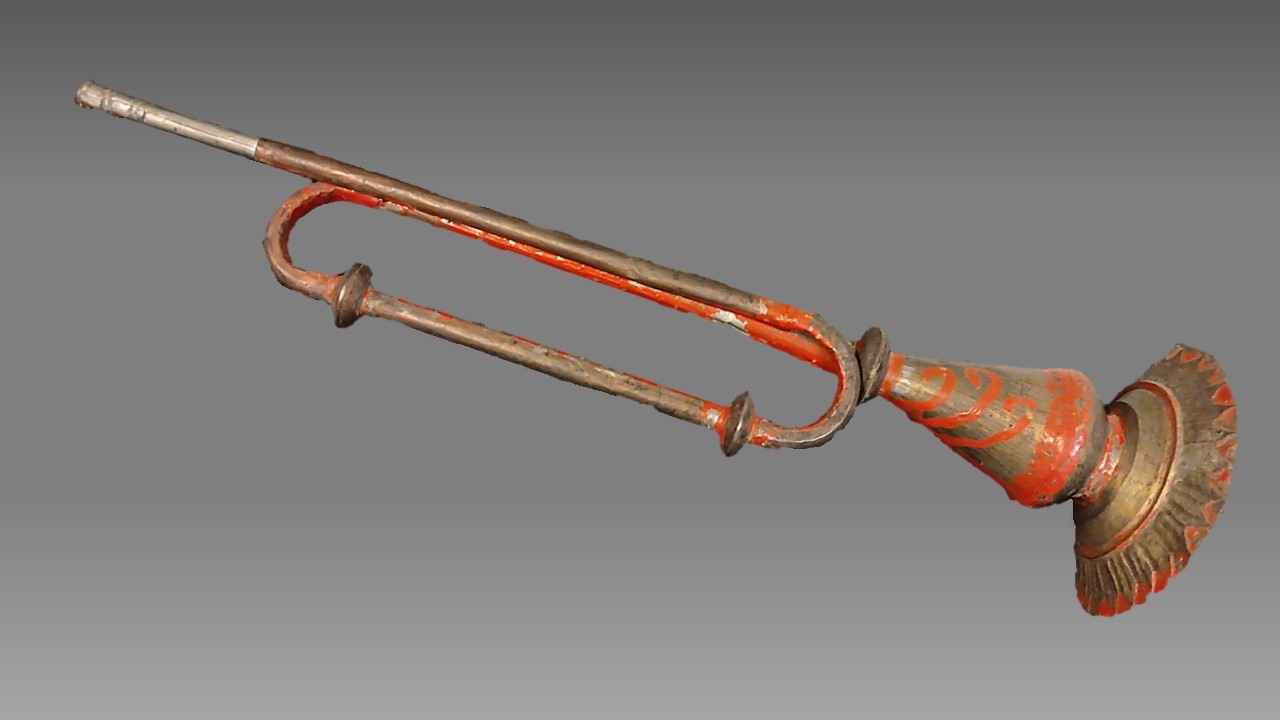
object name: turhi trumpet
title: Turhi (trumpet)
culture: indian or nepalese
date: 1867-1900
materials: metal, paint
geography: india